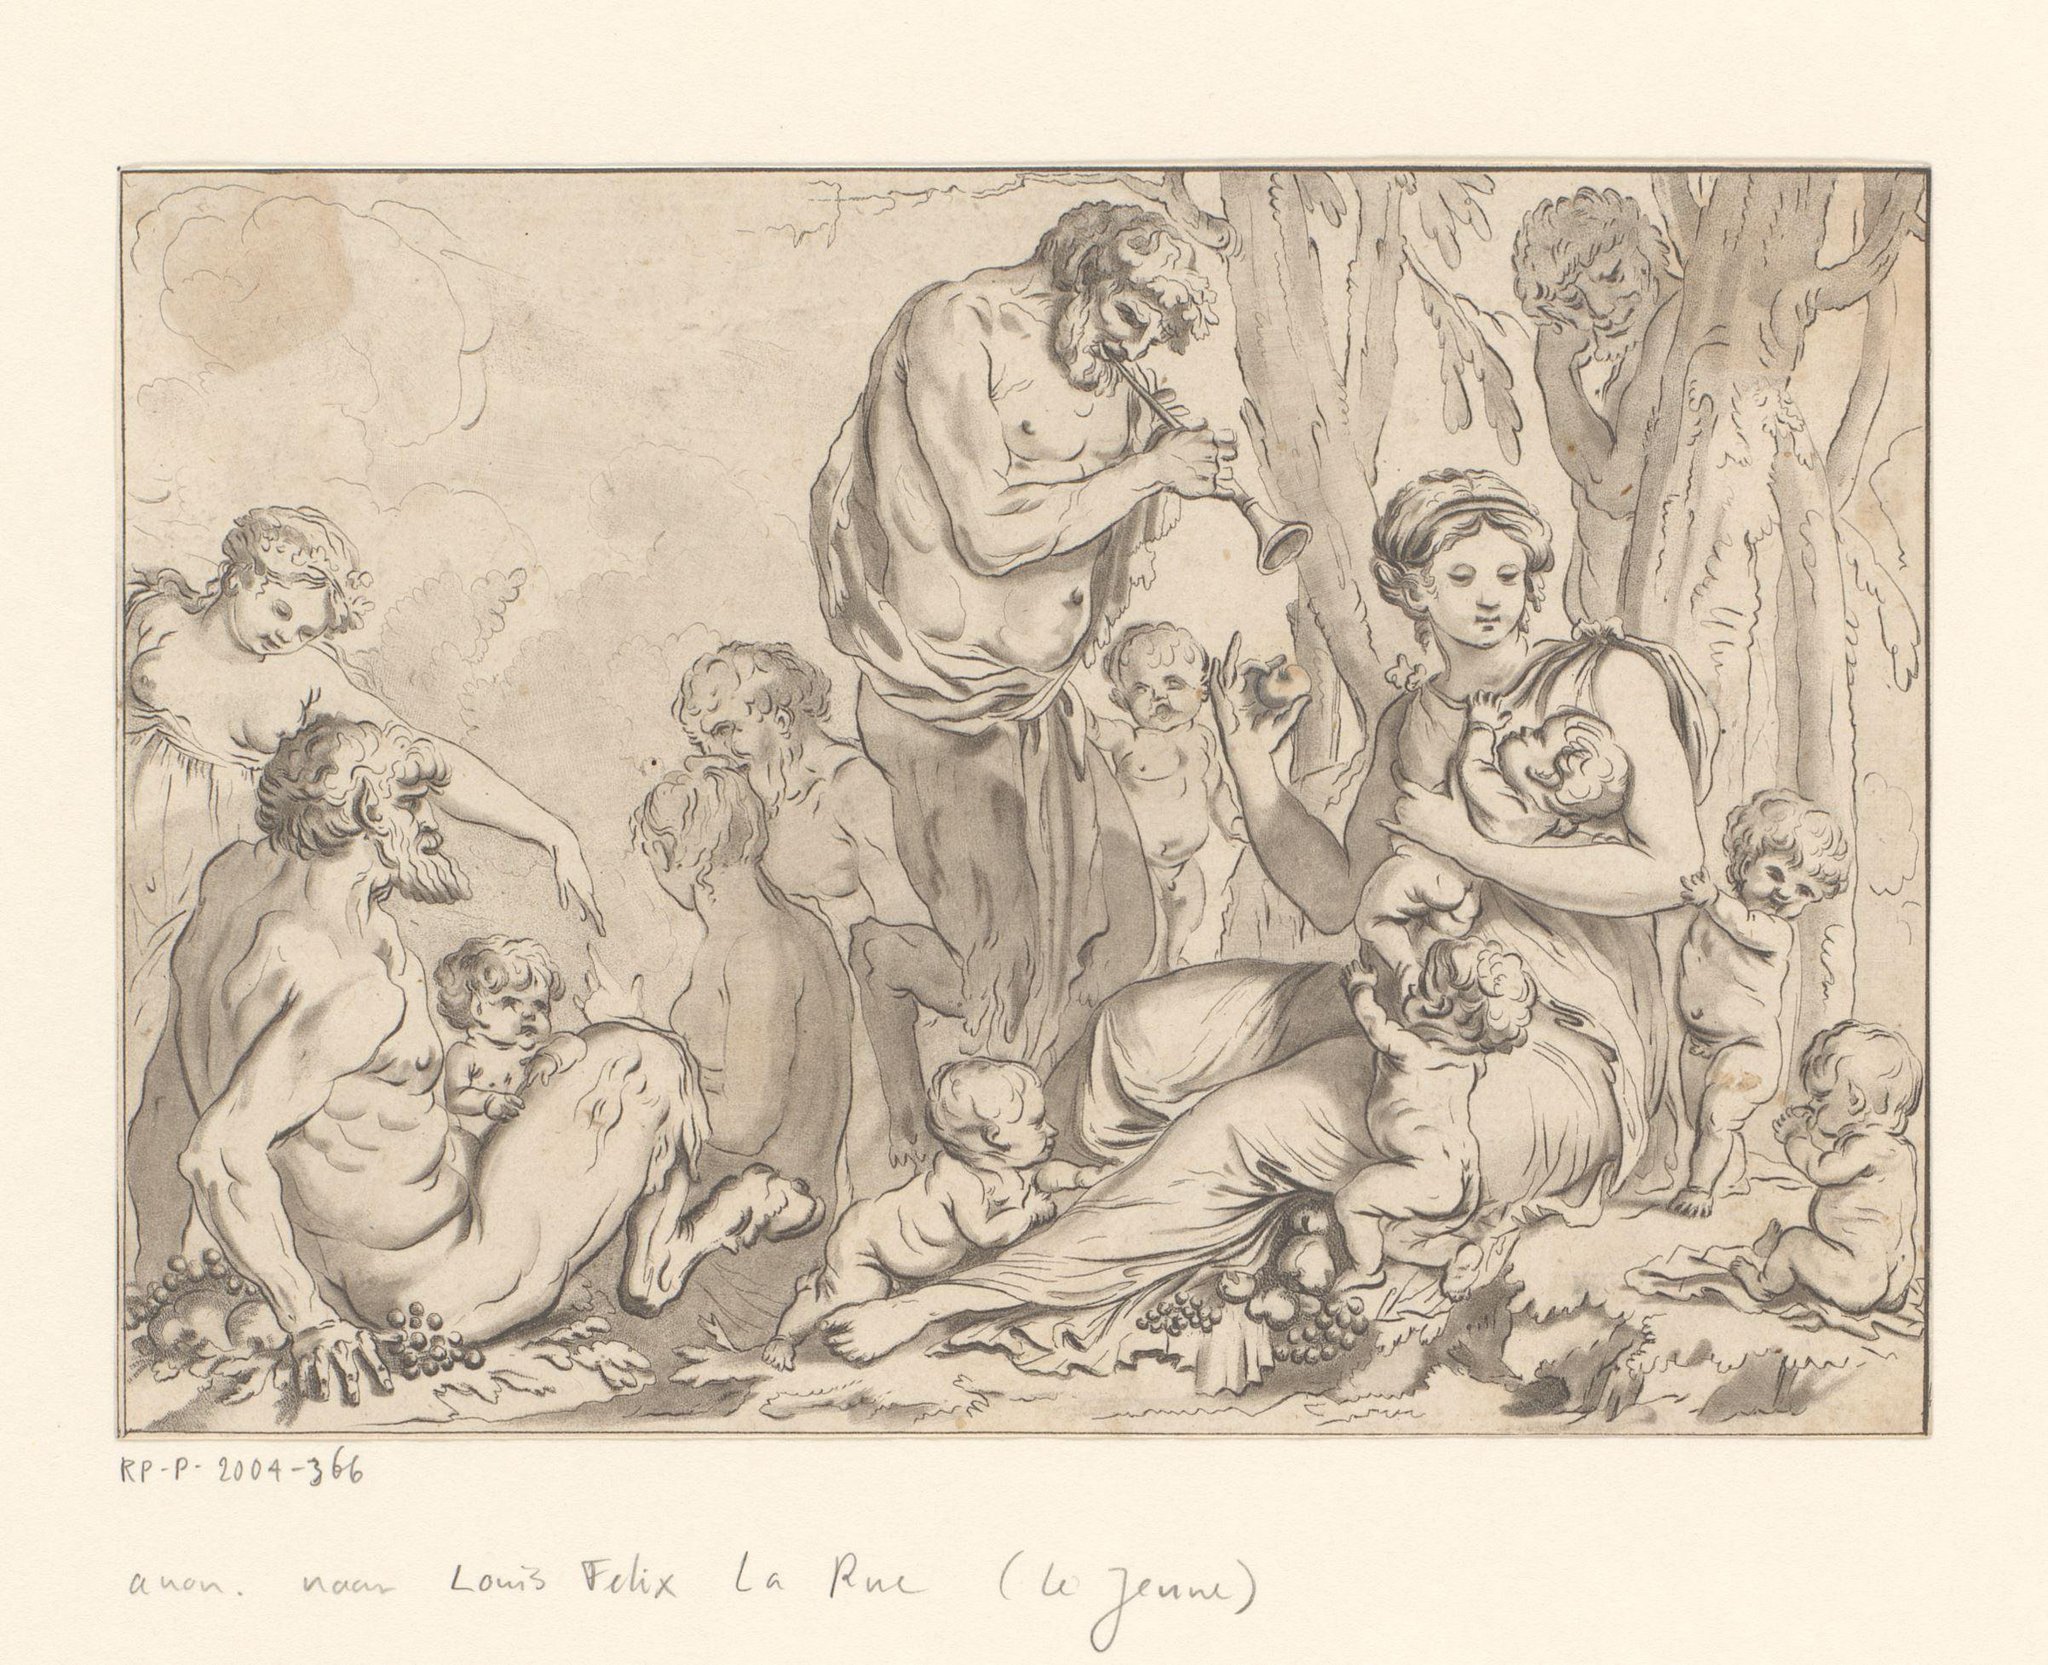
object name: print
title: Saters en nimfen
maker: Anonymous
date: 1750-1800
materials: paper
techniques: aquatint, etching, roulette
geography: france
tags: satyrs, fauns, sileni, nymphs (in general); 'ninfe in commune' (ripa)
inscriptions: collector's mark: Lugt 2760, collector's mark: Lugt 2228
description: Een groepje saters en nimfen bij een bomengroep. Een van de nimfen zit op de grond met een kind in de armen. Vier naakte kinderen om haar heen. Een staande sater speelt op de schalmei.